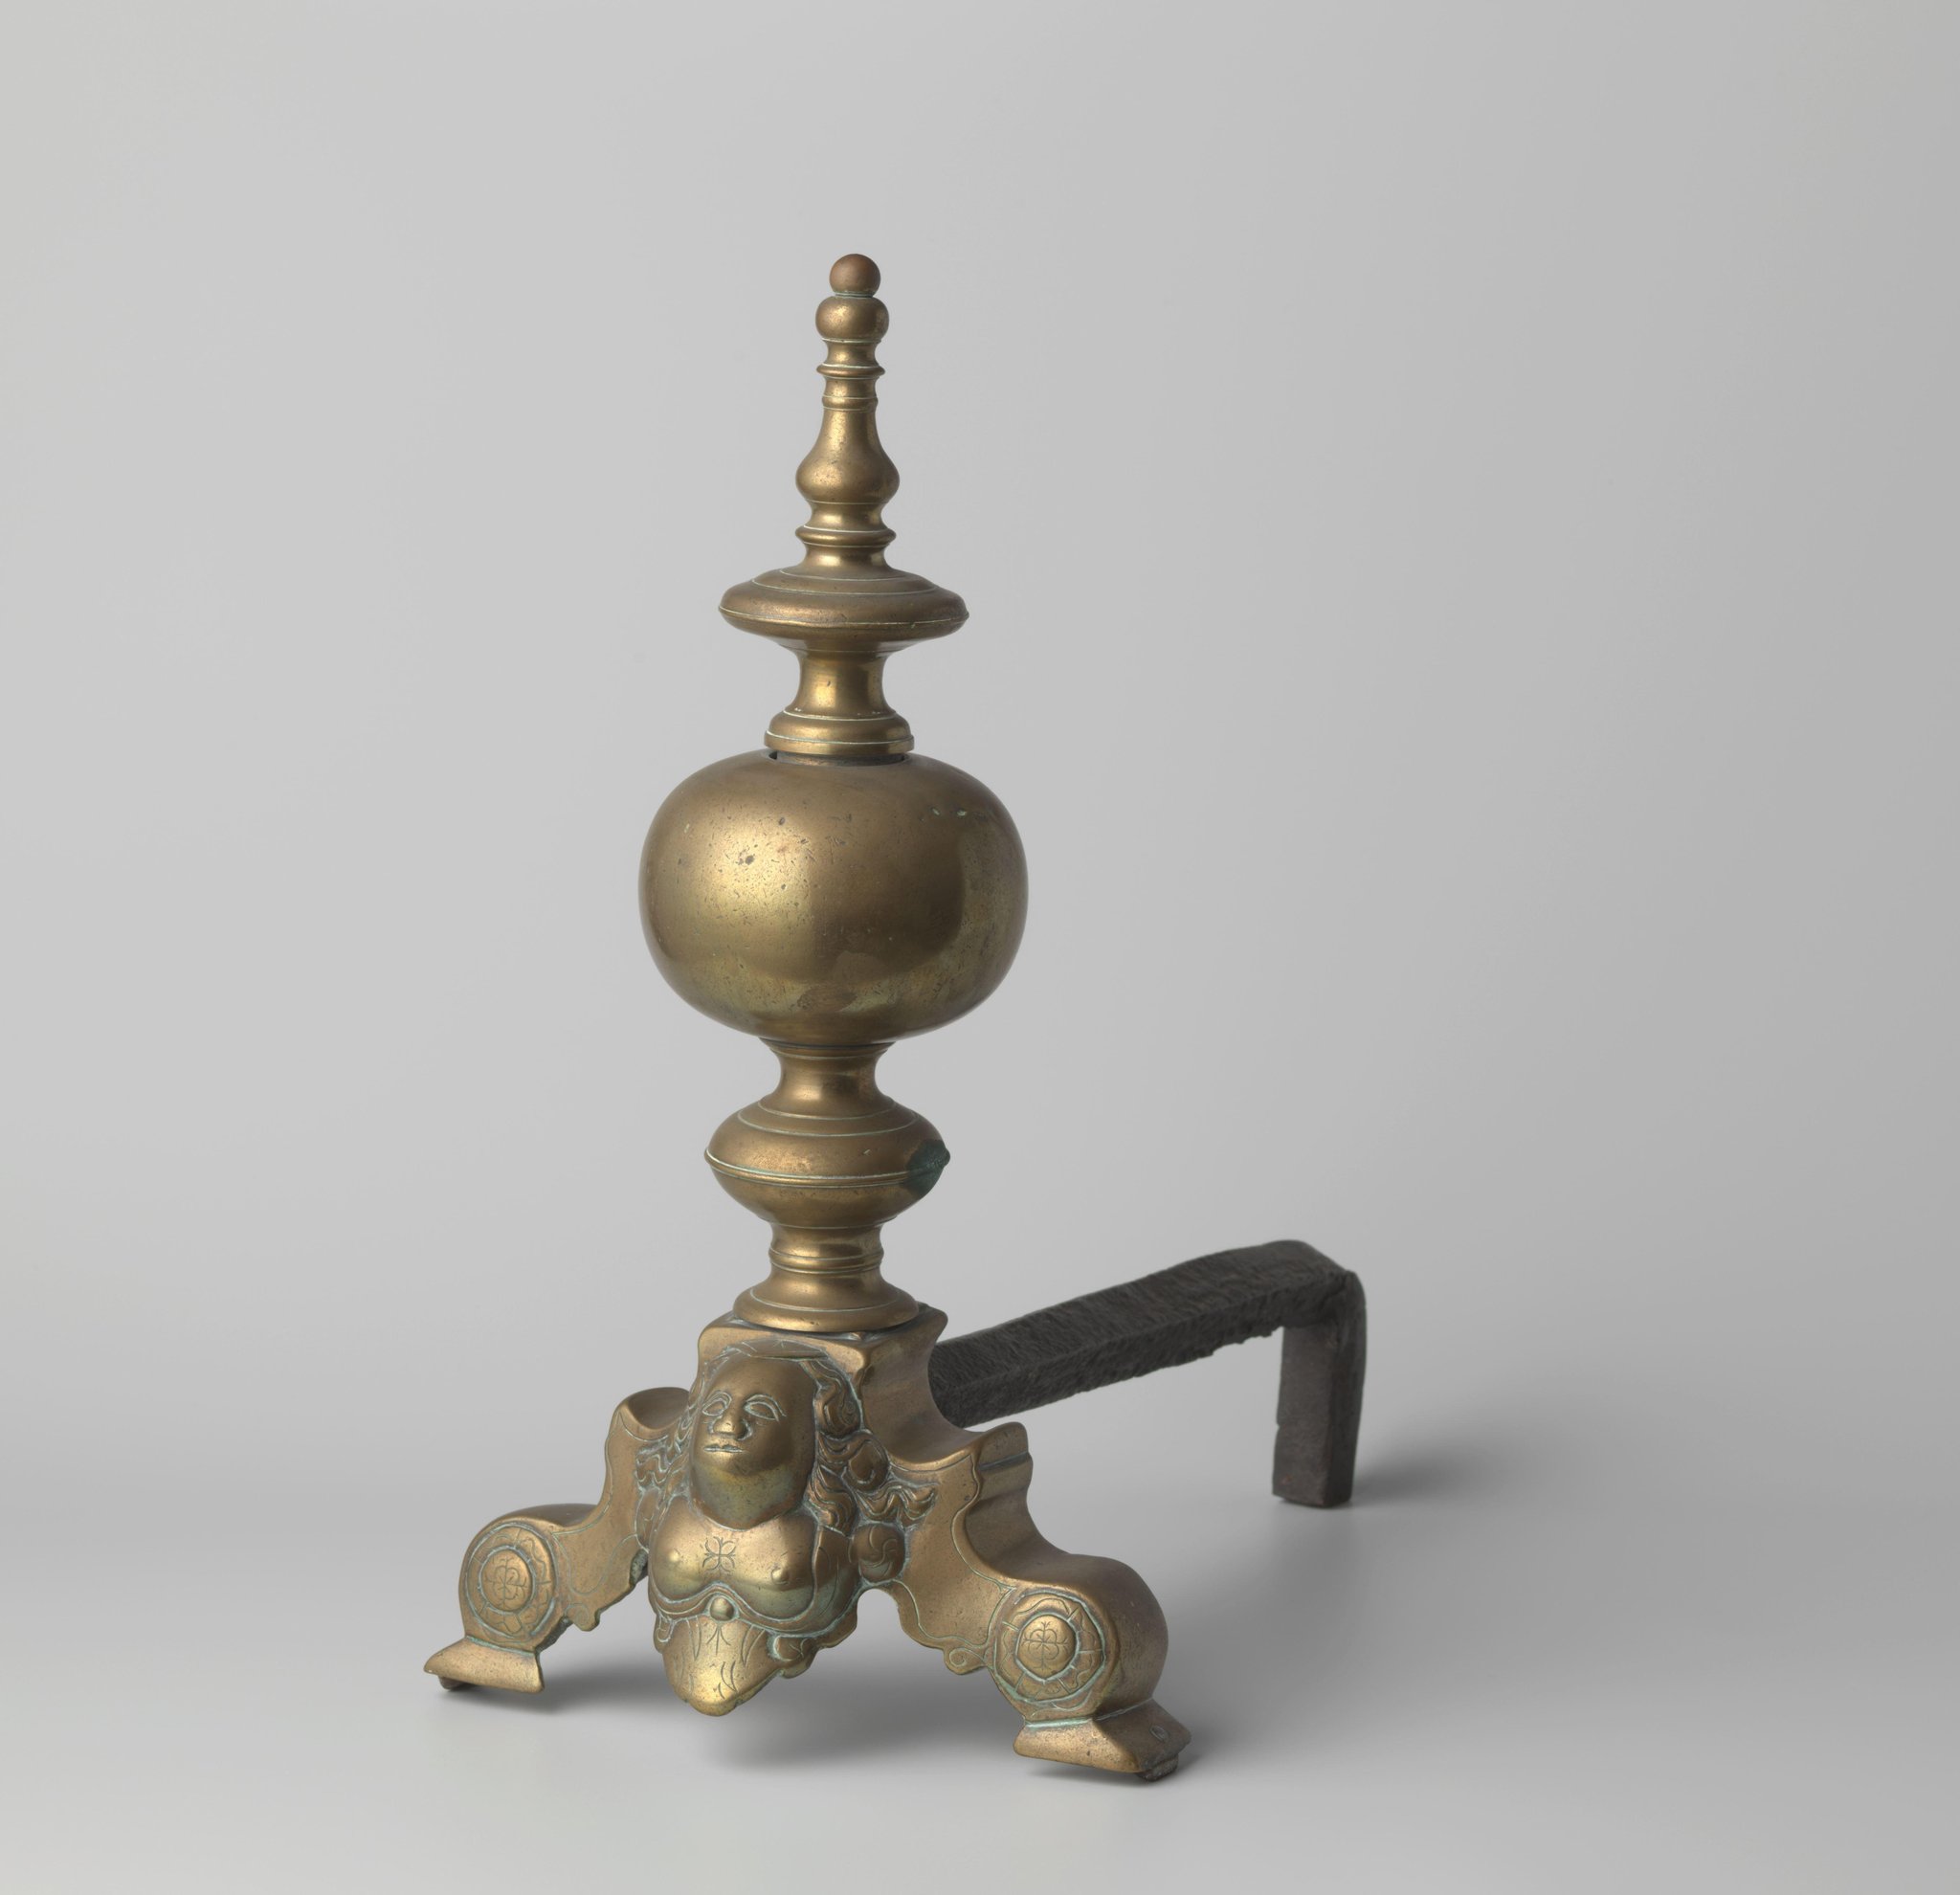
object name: andiron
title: Haardijzer met een versiering bestaande uit het borstbeeld van een vrouw en een bol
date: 1625-1650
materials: brass, iron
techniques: casting, metalworking, forging, riveted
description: De voorwerpen bestaan ieder uit een vier smeedijzeren stangen aaneengeklonken deel, waarop het hout gelegd kan worden en waaraan de in vijf delen gegoten, geciseleerde en gegraveerde versiering van geel koper is bevetsigd. Deze bestaat uit een basis, een versteviging binnen de stam, een stam, een bol en een knop. De basis, waarvan het profiel scherp in- en uitzwenkt, heeft twee met gegraveerde rozetten versierde voeten en is in het midden gedecoreerd met het borstbeeld van een vrouw. De geprofileerde stam heeft een nodus. De bol is glad. De rijk geprofileerde knop heeft o.a. een nodus en een baluster. Bij a zijn de versieringsonderdelen los gemonteerd. Bij b is een stuk afgebroken van de basis, de rechter voet vernieuwd, en zijn de gesoldeerde knop en stam misschien eveneens vernieuwd.